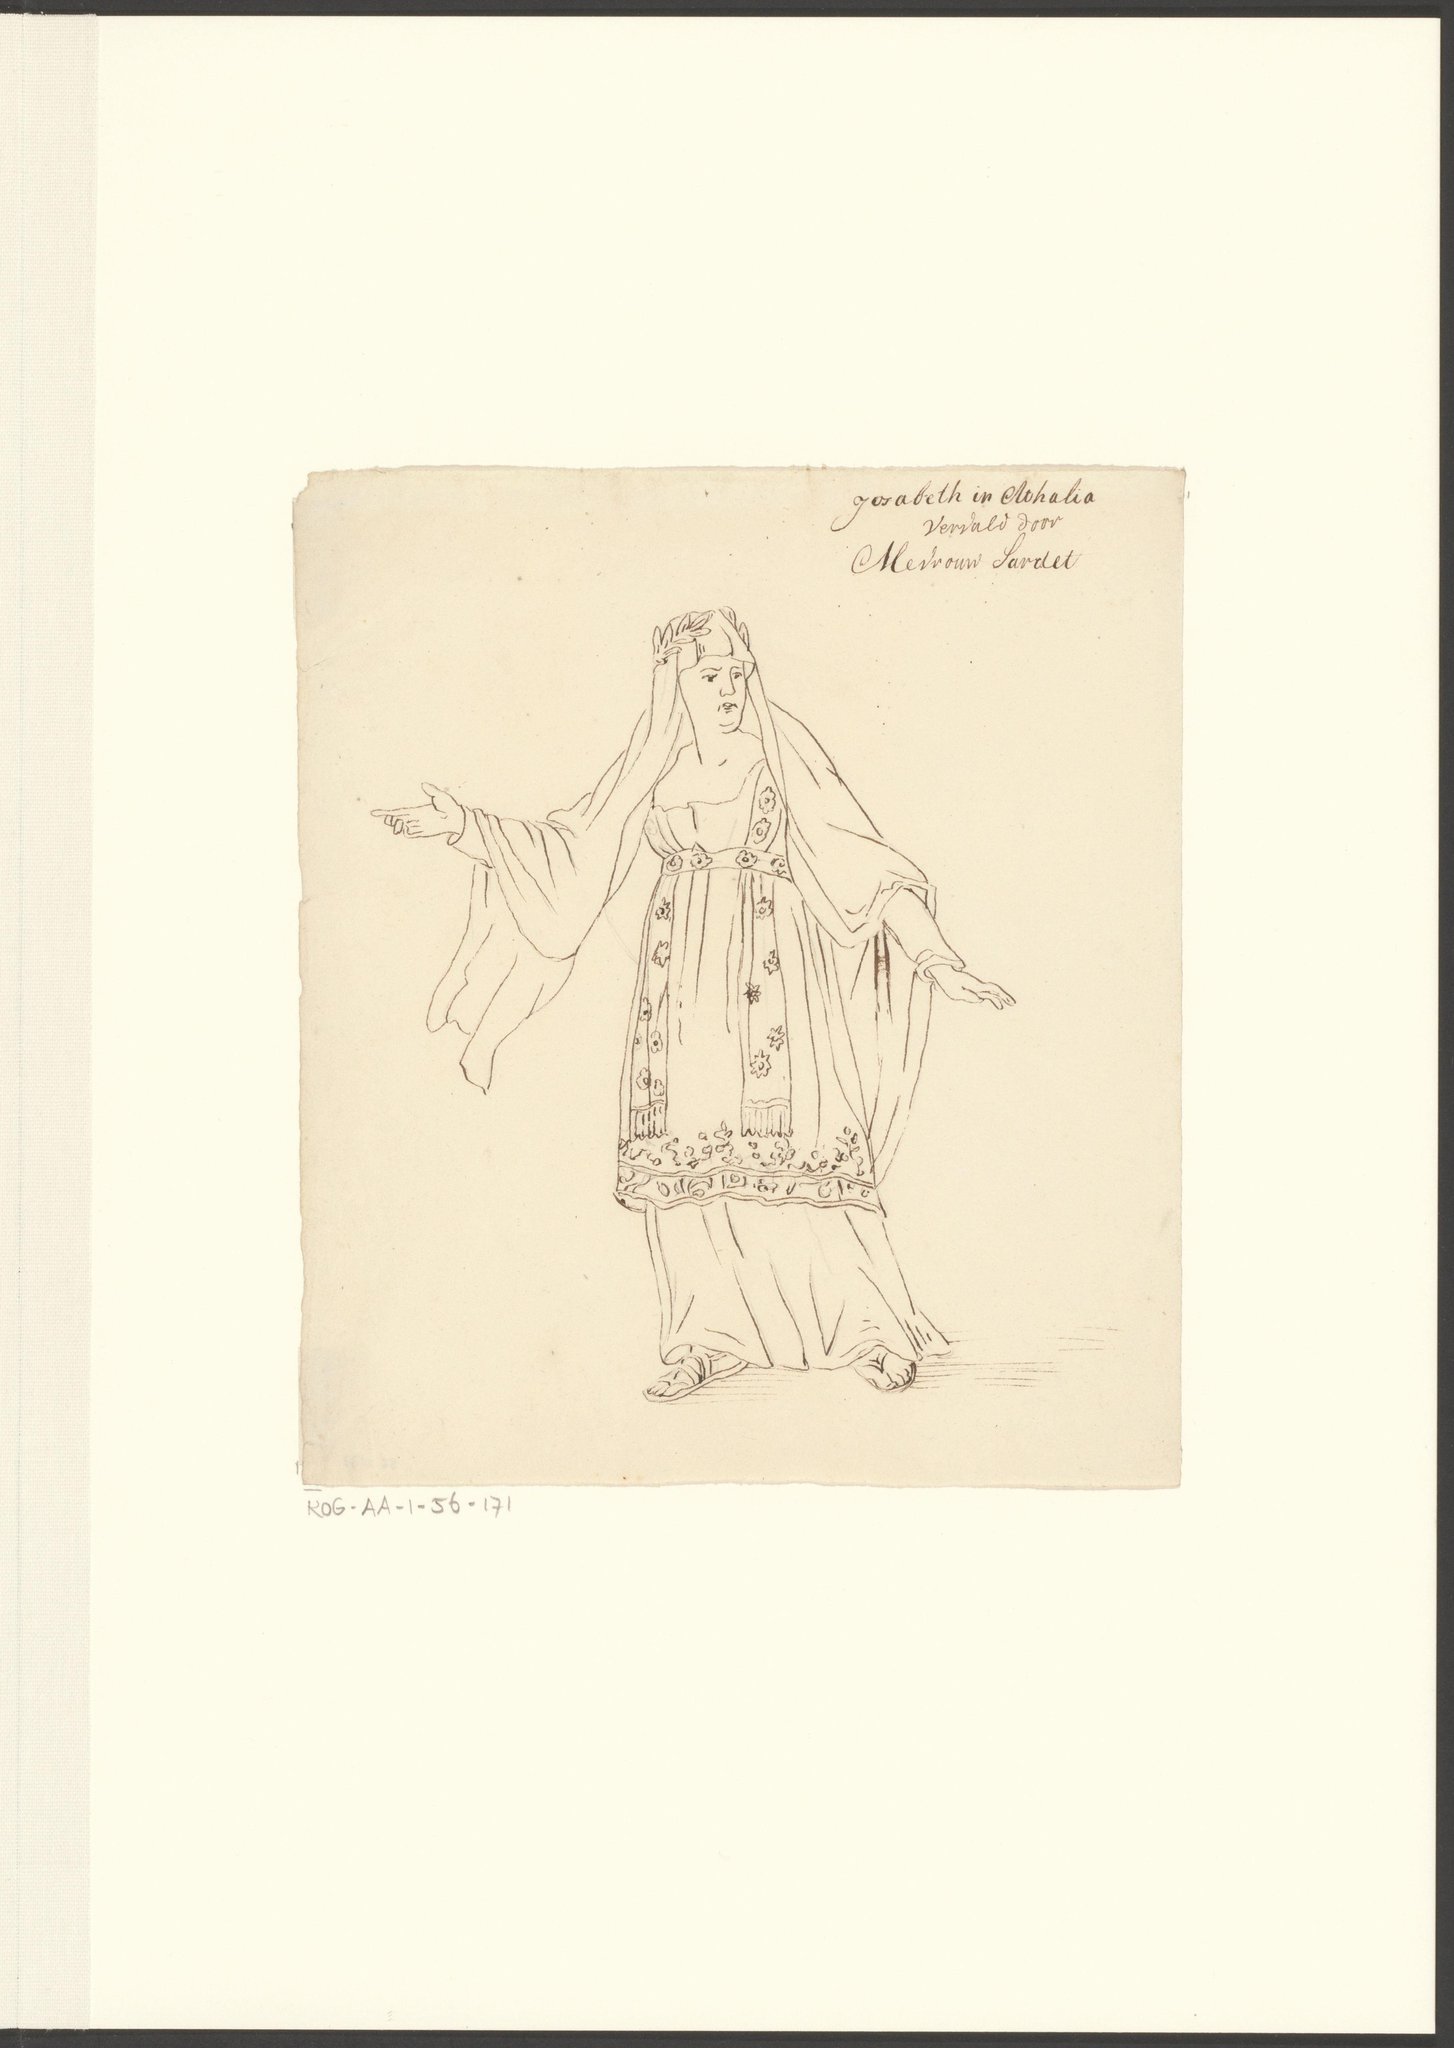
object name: drawing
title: Portret van toneelspeelster Jacoba Wouters-Sardet in de rol van Josabeth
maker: johannes jelgerhuis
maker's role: draughtsman, painter, print maker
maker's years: 1770-1836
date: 1780-1813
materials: ink, paper, pencil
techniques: pen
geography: amsterdam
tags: the hague, historical persons - bb - woman, portrait of actor, actress, actor (on the stage), amsterdam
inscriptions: inscription: ‘josabeth in Athalia / Vervuld door / Mevrouw Sardet’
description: Voorbereidende tekening op de prentserie Acteurs en actrices in verschillende rollen van Johannes Jelgerhuis.